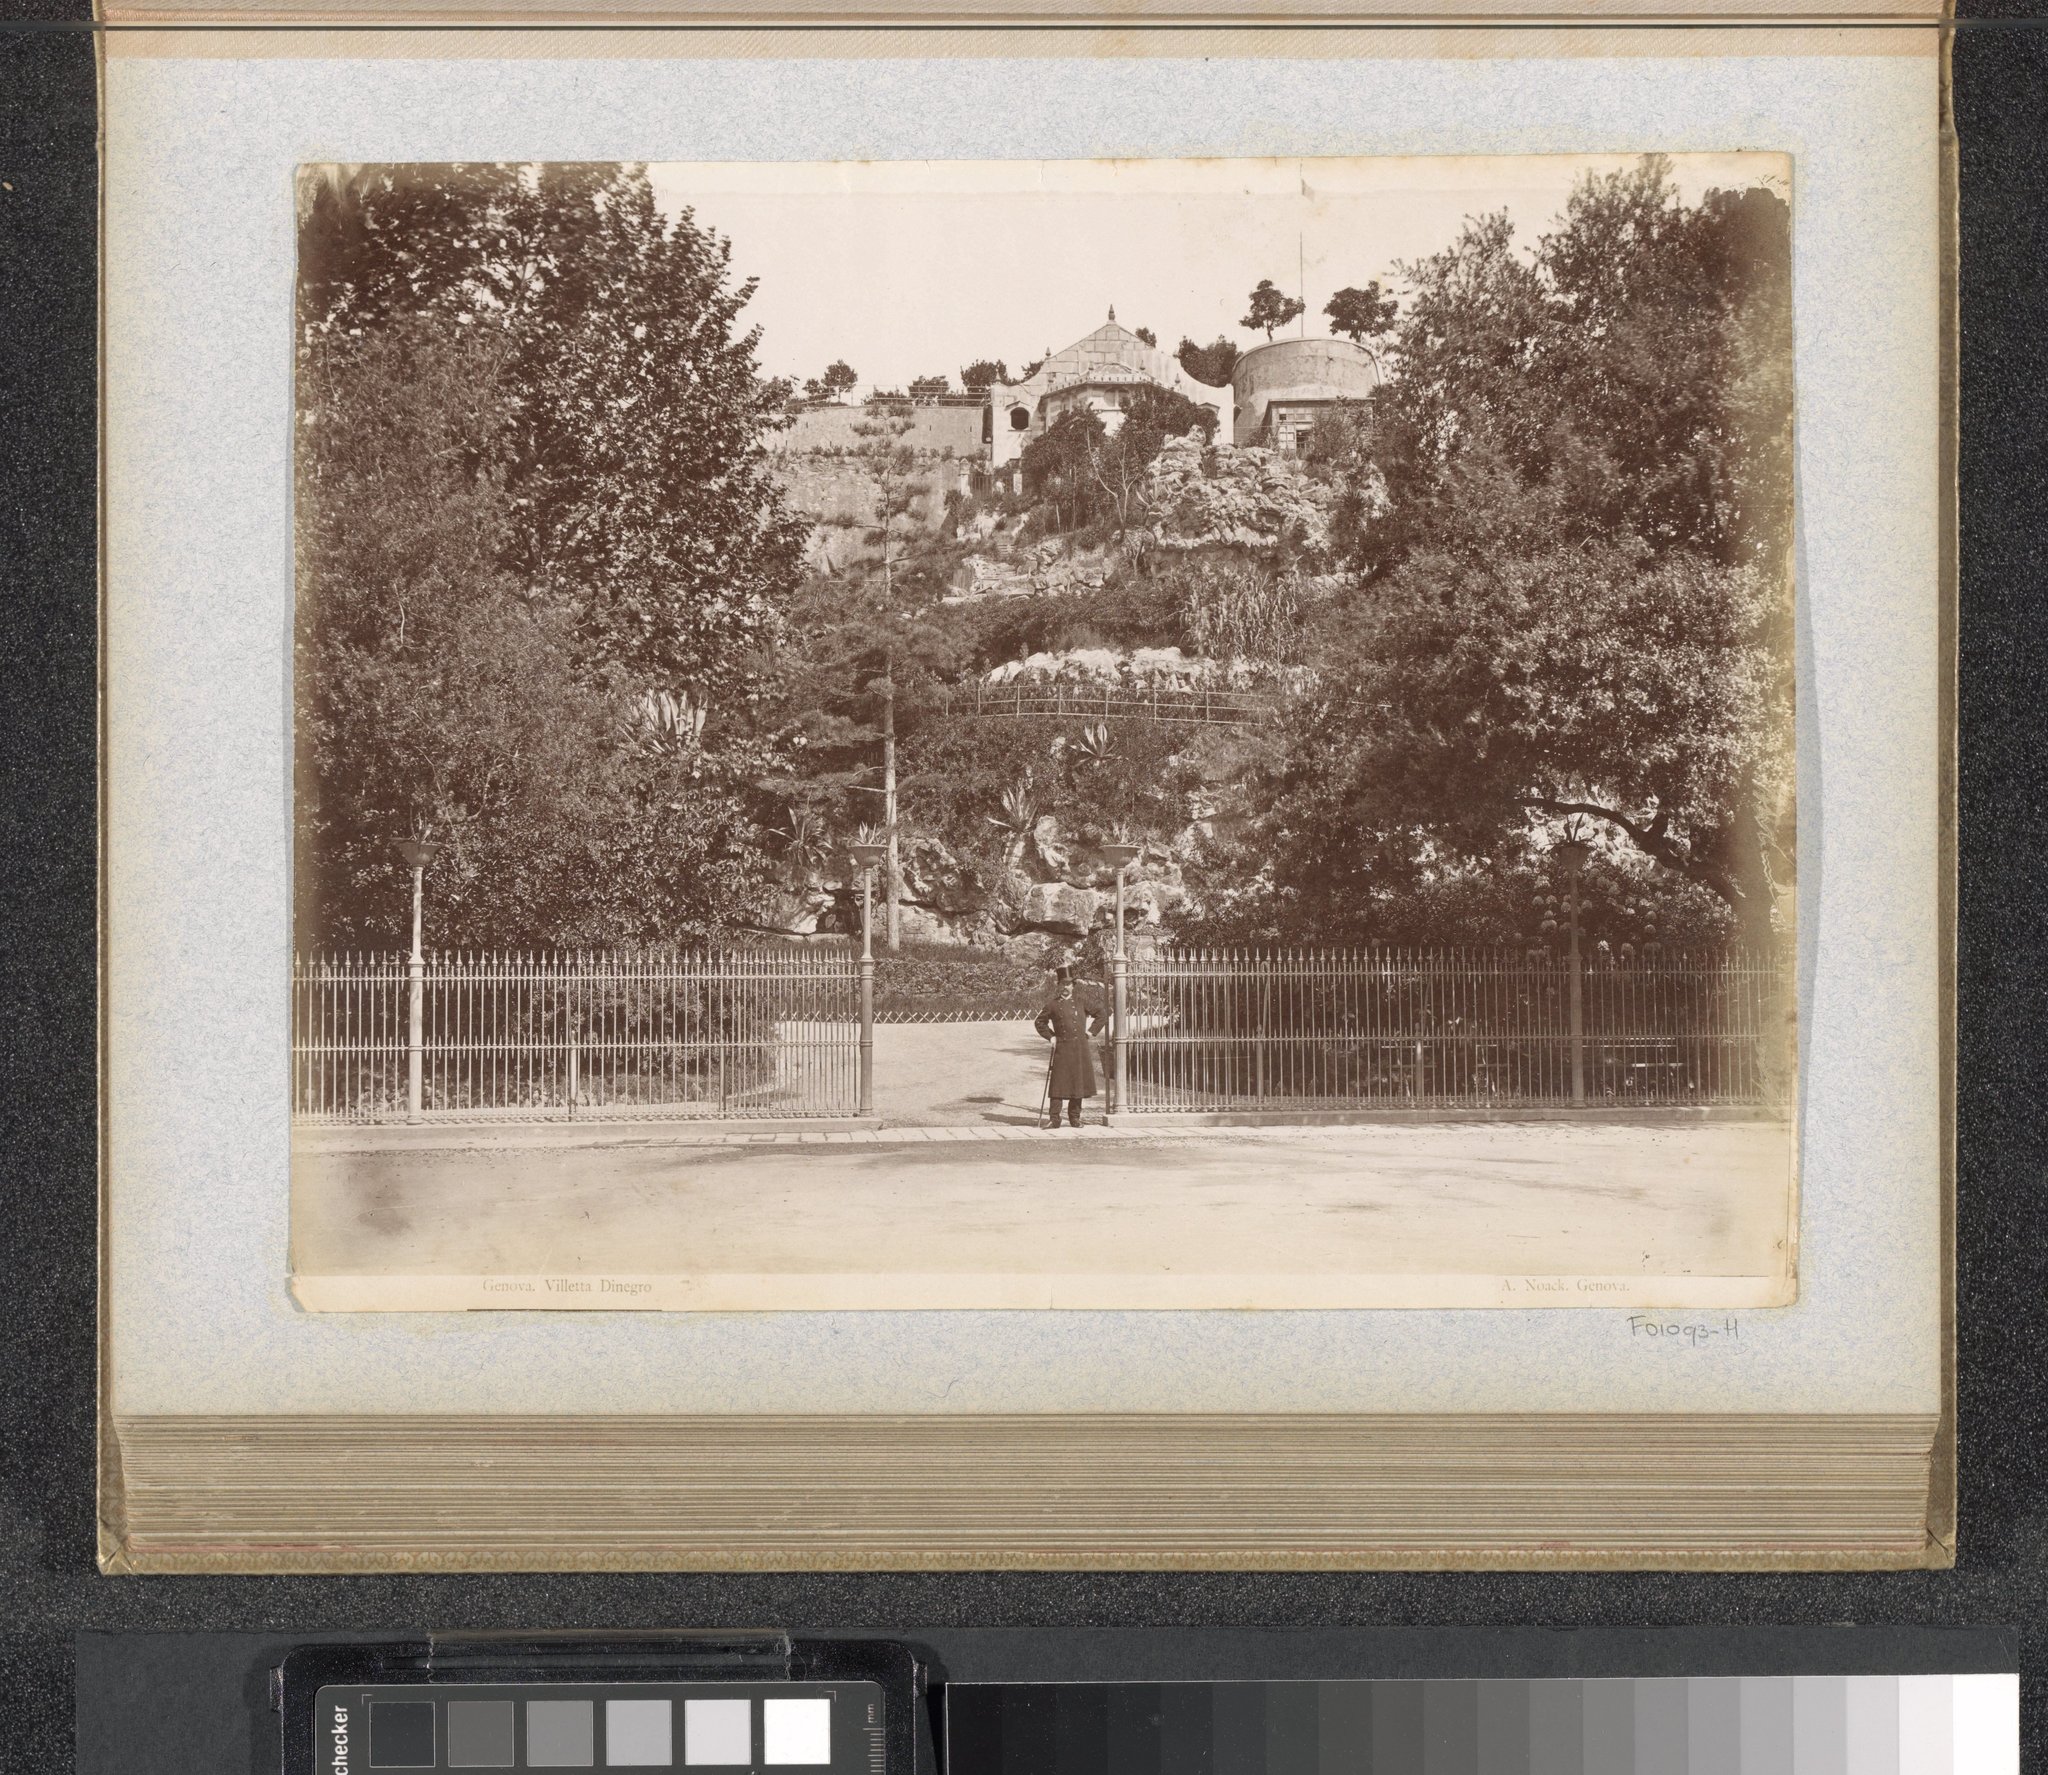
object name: photograph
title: Man staand bij de ingang van het park Villetta Dinegro in Genua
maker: alfredo noack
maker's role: fotograaf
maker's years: 1833-1895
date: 1870-1890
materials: paper, photographic support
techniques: albumen print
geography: genoa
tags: fence, wall, paling, rural housing, e.g. country-house, villa, cottage, public gardens, park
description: Onderdeel van Reisalbum met foto's van bezienswaardigheden in Genua, Florence en Venetië.